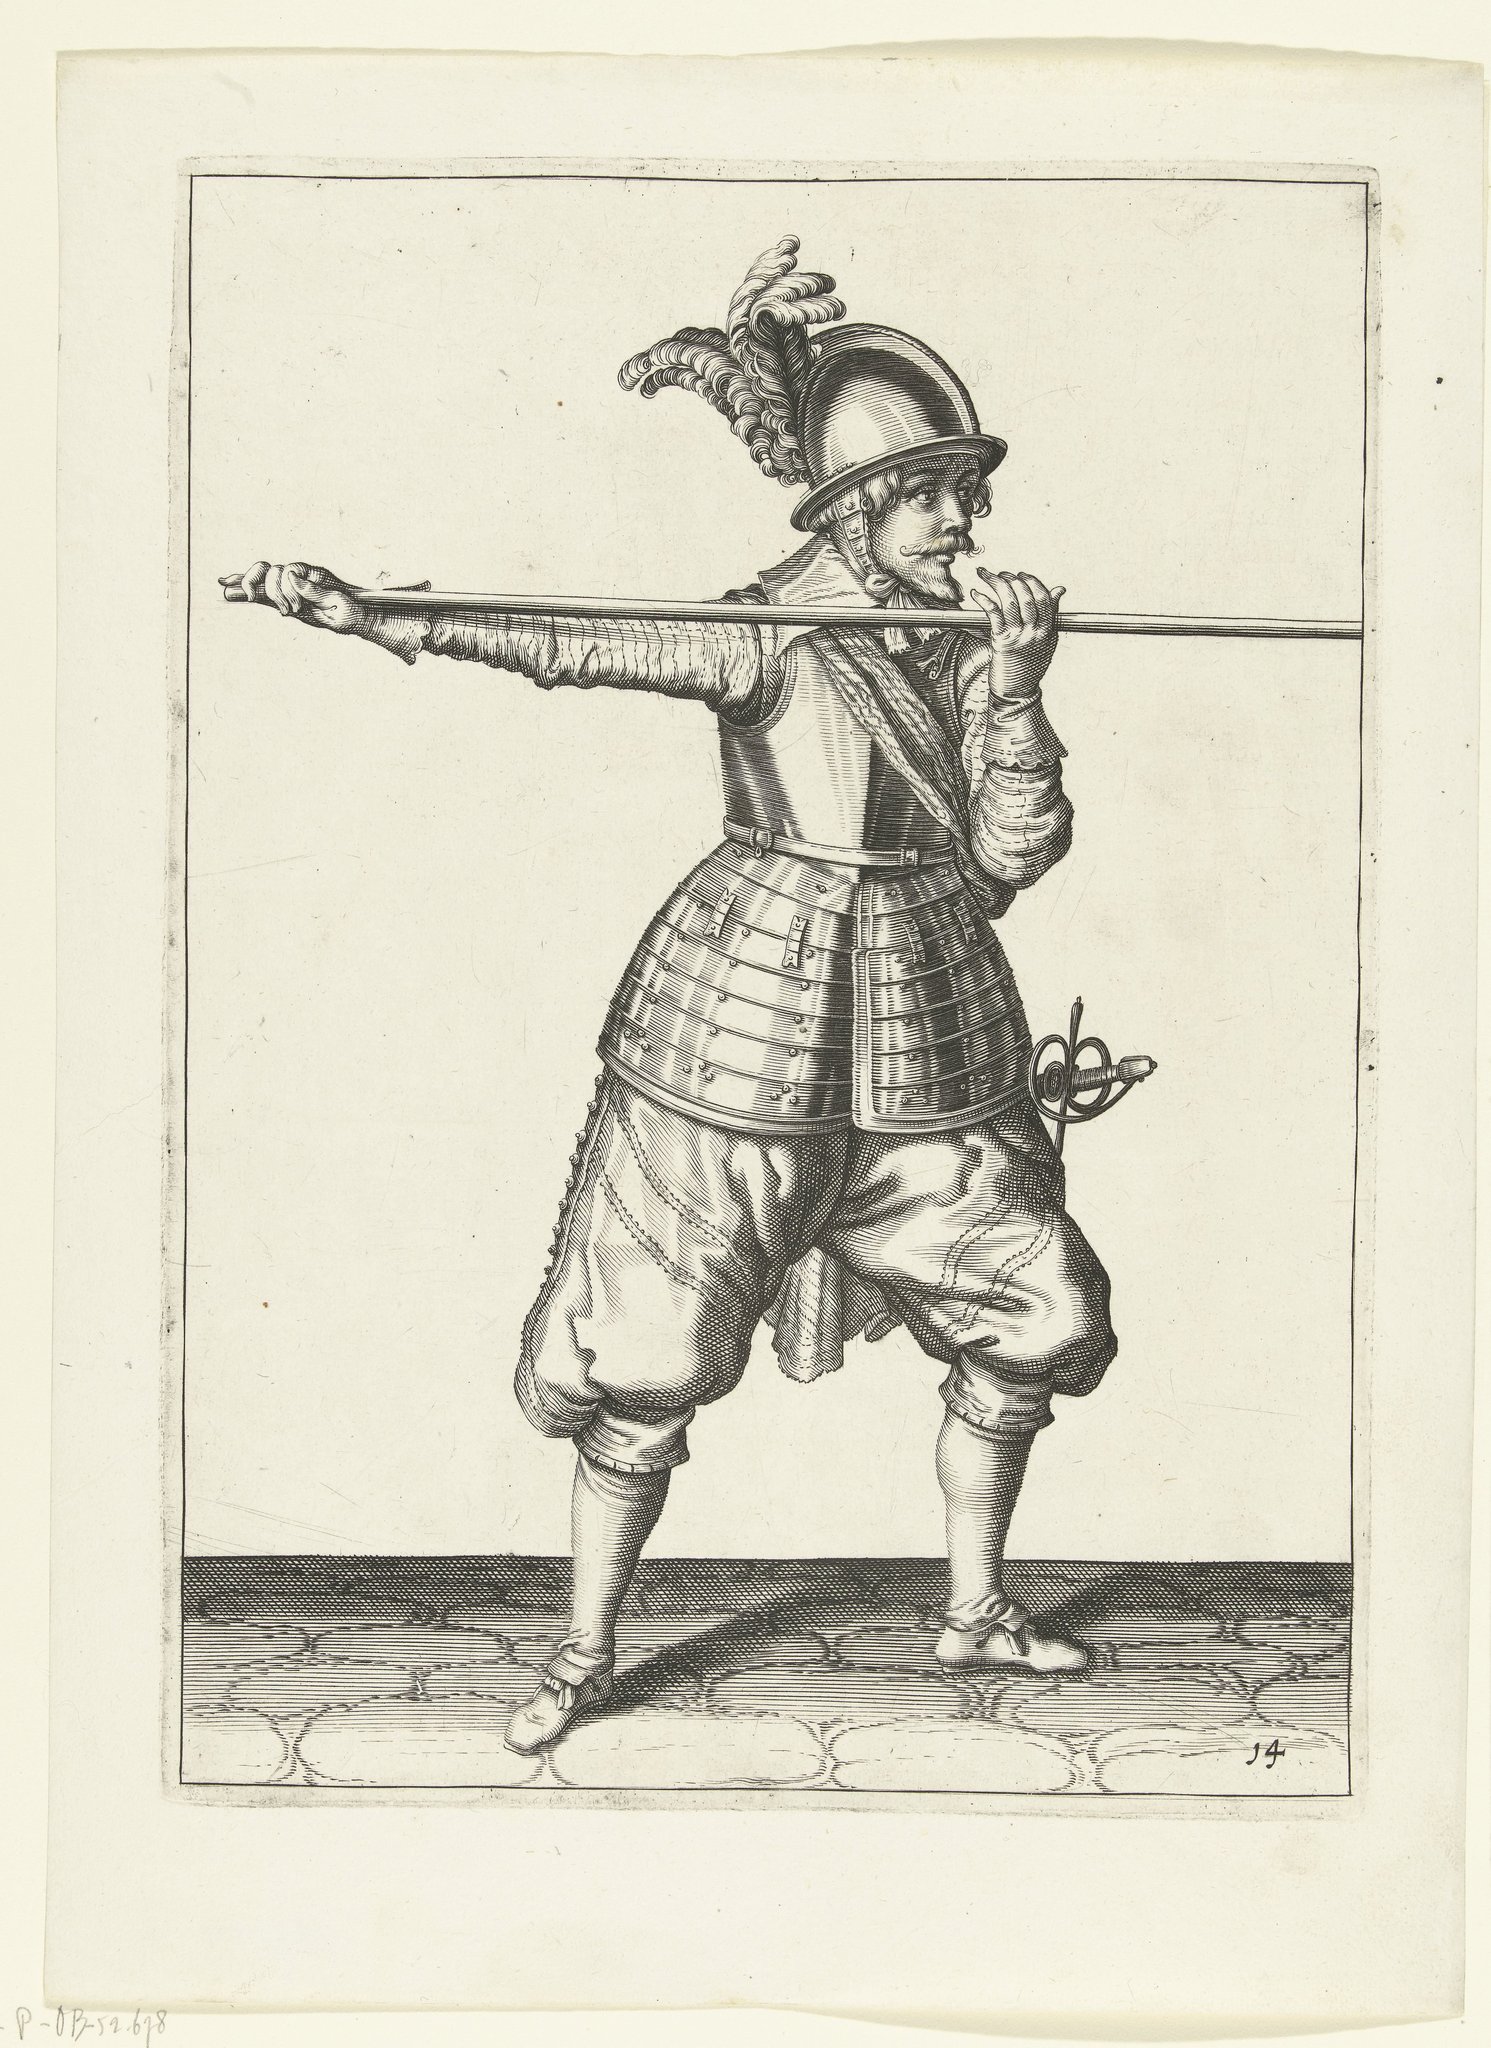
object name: print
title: Soldaat die zijn spies met beide handen horizontaal op schouderhoogte draagt, zijn rechterhand bij de voet van het wapen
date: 1597-1607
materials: paper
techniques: engraving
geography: netherlands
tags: manoeuvre ~ military training, warfare; military affairs (+ mercenary troops, e.g.: lansquenets), helved weapons, polearms (for striking, hacking, thrusting): lance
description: Een soldaat, ten voeten uit, die een spies (lans) met beide handen horizontaal op schouderhoogte draagt, zijn rechterhand bij de voet van het wapen. Dit is de derde handeling voor het laten zakken van de spies om onder een overwelving door te kunnen. Deze prent is onderdeel van de reeks van 32 genummerde prenten van spiesdragers uit de Wapenhandelinghe.